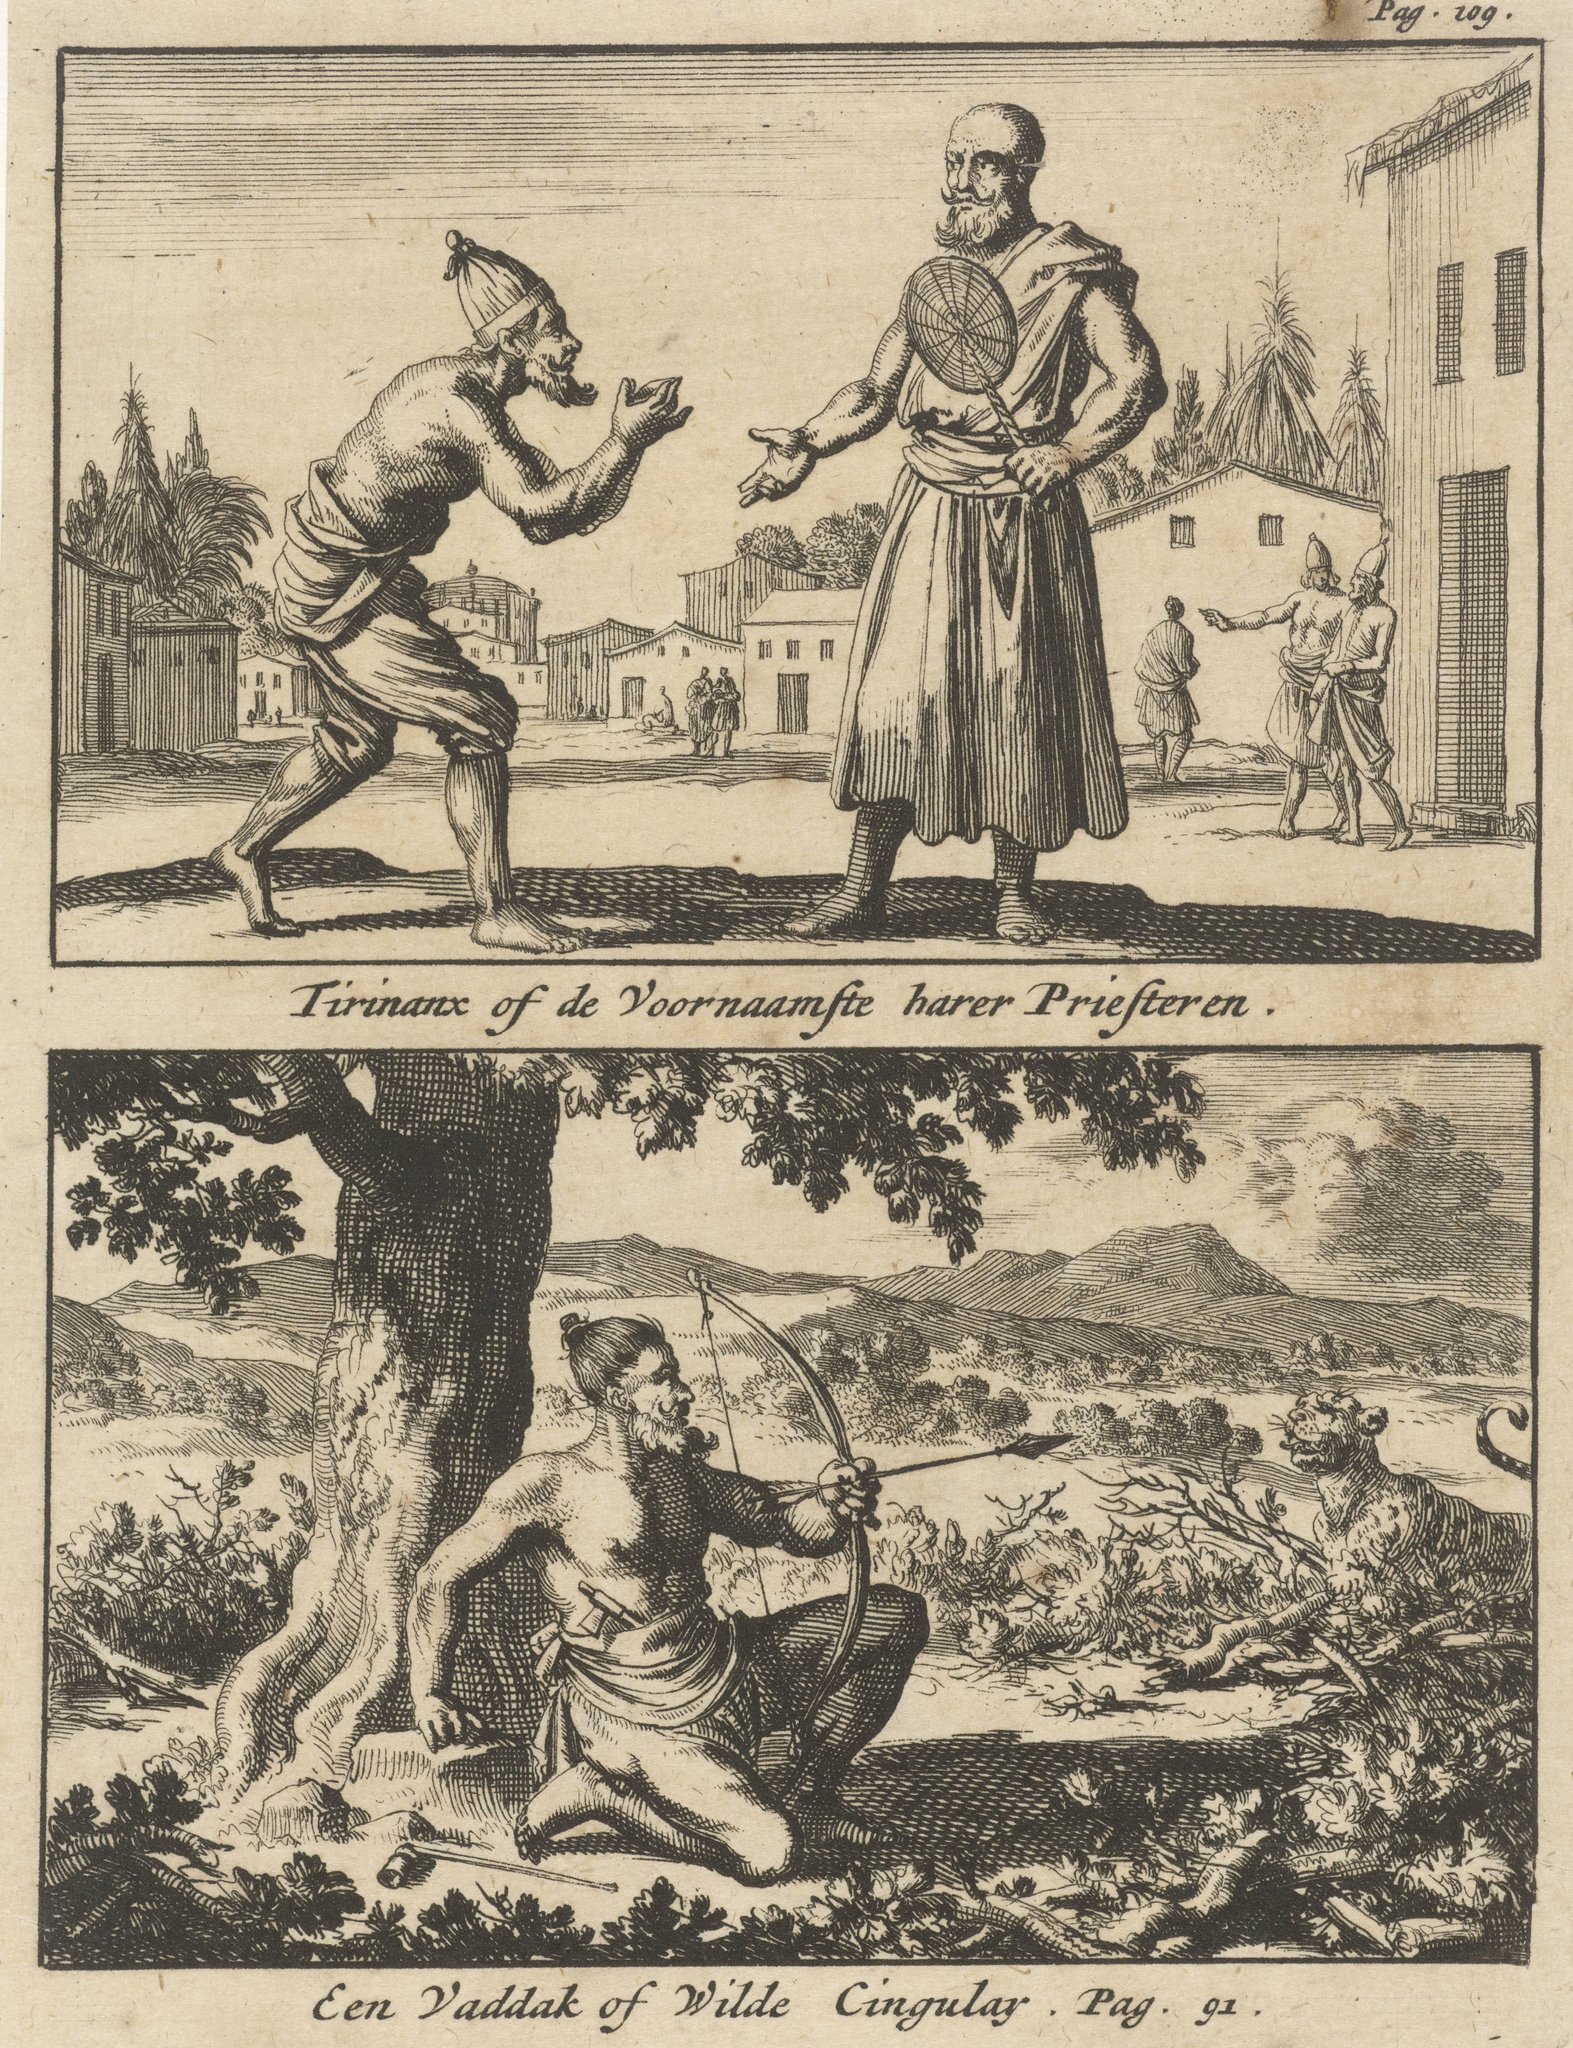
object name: book illustration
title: Figuur smekend voor een priester / Jager richt zijn pijl en boog op een tijger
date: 1692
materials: paper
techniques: etching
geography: utrecht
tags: priest ~ hinduism, buddhism, jainism, beasts of prey, predatory animals: tiger, archer's weapons: bow and arrow, hunter, sri lanka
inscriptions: collector's mark: Lugt 2228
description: Illustratie uit: Knox, Robert. t'Eyland Ceylon in sĳn binnenste, of't koningrijck Candy. Utrecht: Willem Broedelet, 1692.